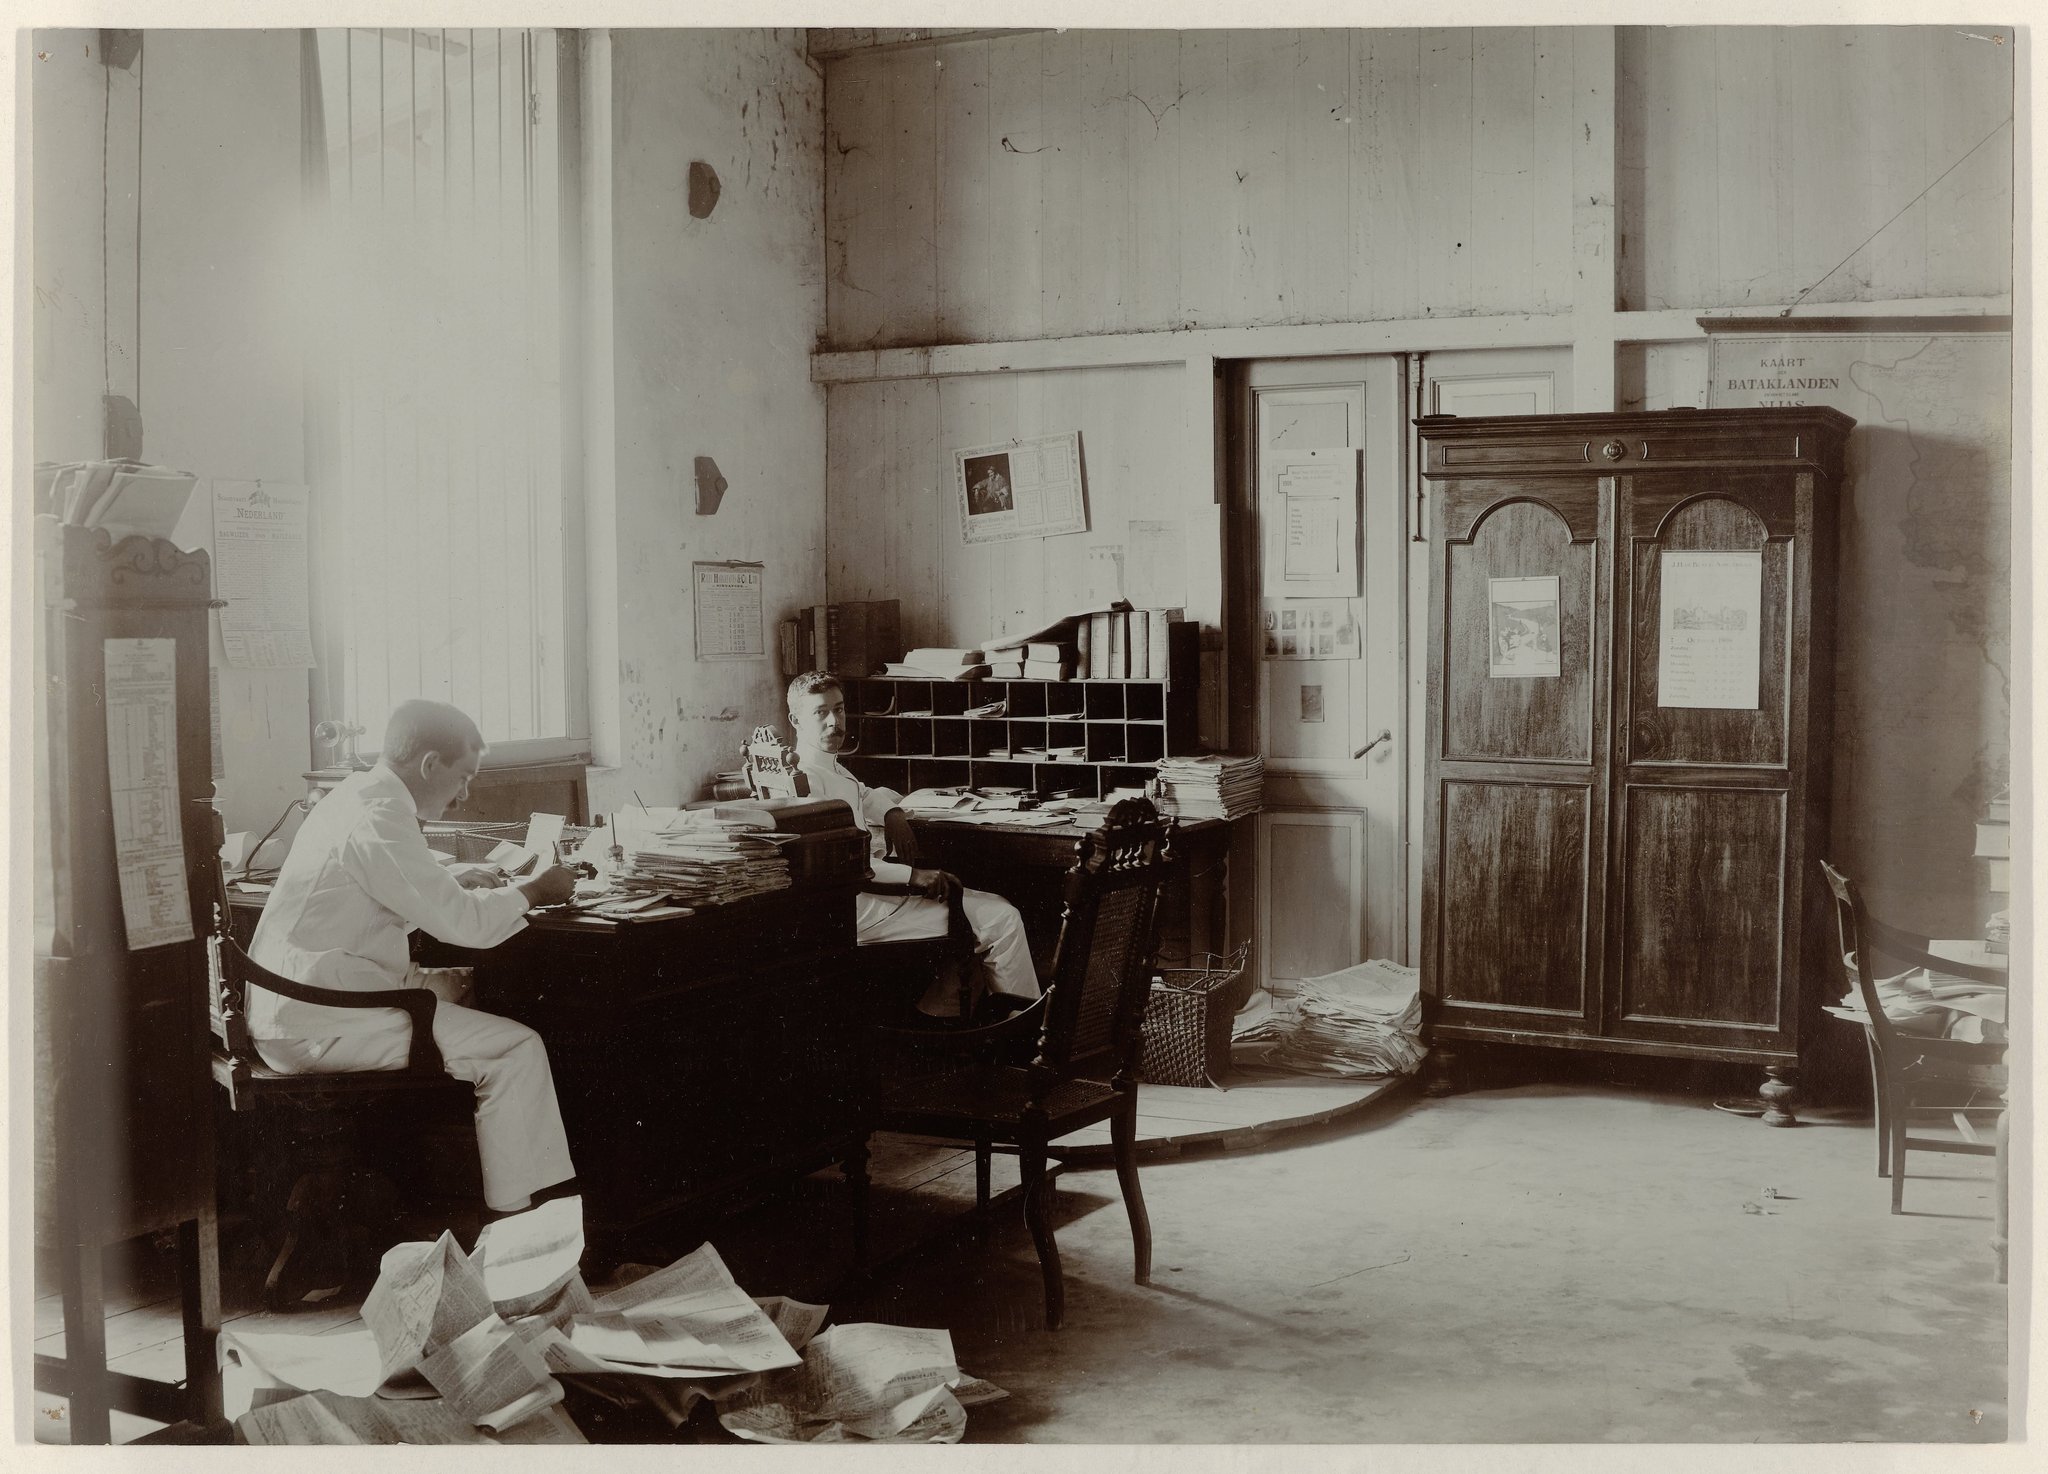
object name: photograph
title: Kamer van de redactie van de Deli Courant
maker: Anonymous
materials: photographic support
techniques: collodion silver print, gelatin silver print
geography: medan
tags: dutch east indies, the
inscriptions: inscription: ‘Redactie’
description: De kamer van de redactie van de Deli Courant te Medan, met twee redacteuren zittend achter hun bureaus. Onderdeel van een aparte groep van negen foto's uit 1908 binnen de gehele groep van 49 losse zwart-wit foto's van verschillend formaat over de uitgeverij en drukkerij van de krant Deli Courant in Medan in de periode 1885-1947.